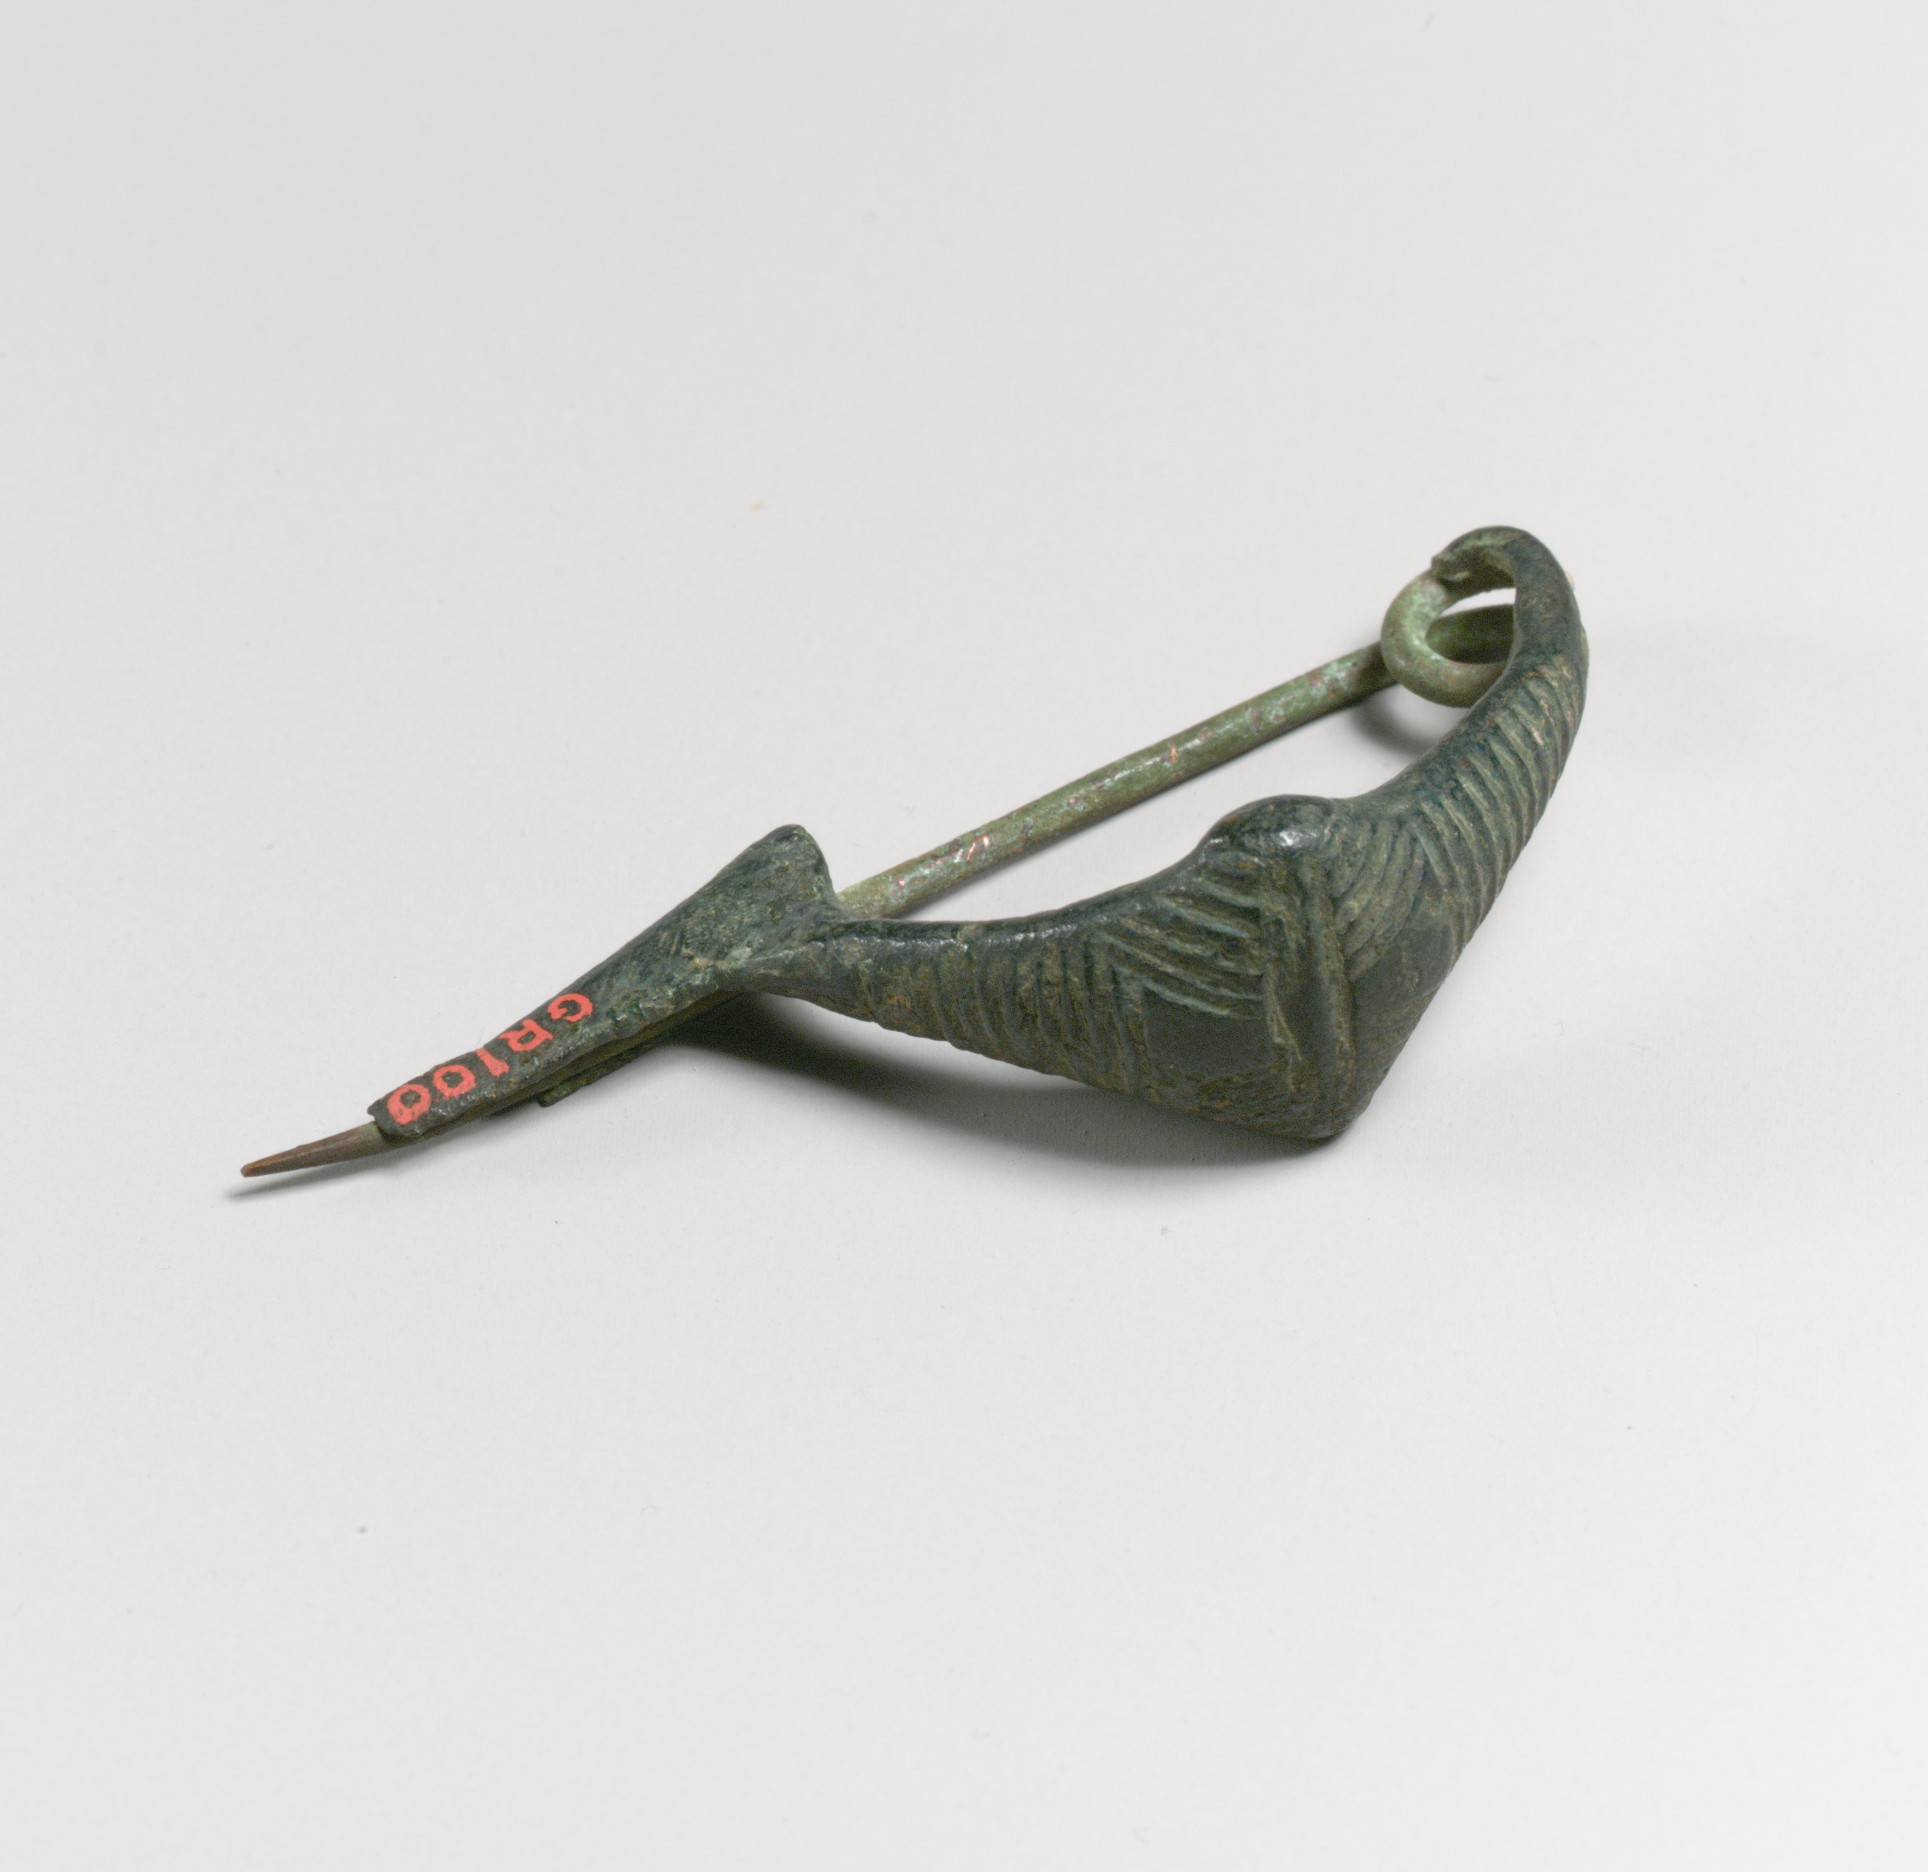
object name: fibula, boat shaped type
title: Fibula, boat-shaped type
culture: italic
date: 800-501 BCE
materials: bronze